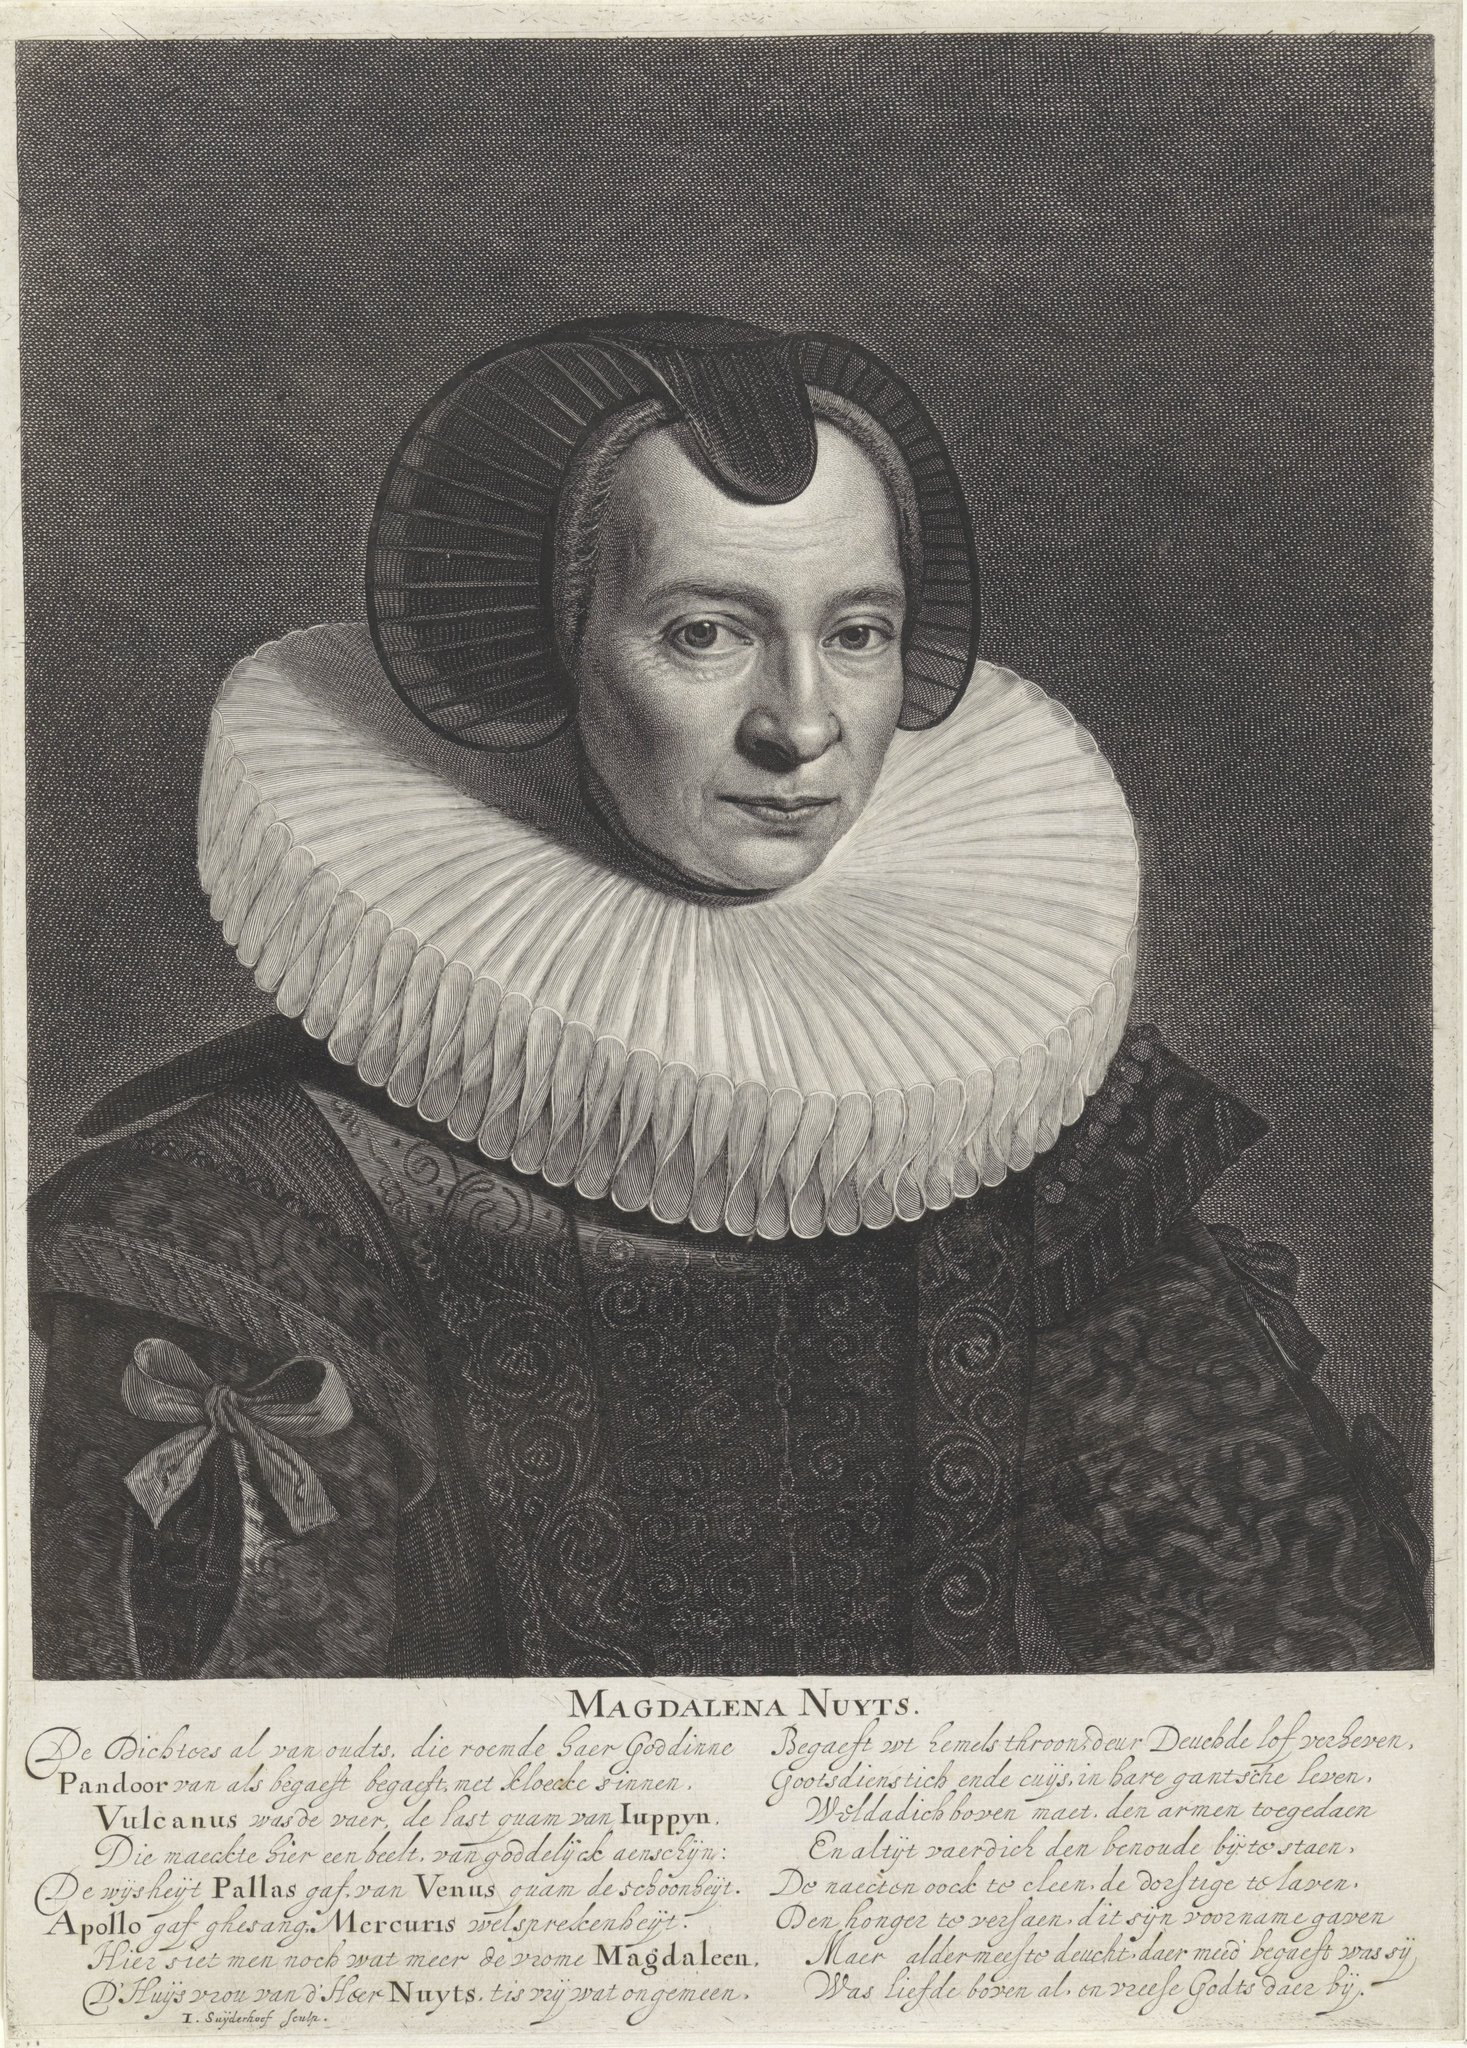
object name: print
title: Portret van Magdalena Nuyts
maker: jonas suyderhoef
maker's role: draughtsman, print maker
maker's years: 1613-1686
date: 1631-1686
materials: paper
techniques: engraving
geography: haarlem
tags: the hague, head-gear: cap (+ women's clothes), neck-gear ~ clothing (with name) (+ women's clothes)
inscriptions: title: ‘MAGDALENA NUYTS’, signature: ‘I. Suyderhoef sculp.’, poem: ‘De dichters al van ouds, die roemde haer Godinne...Hier siet men noch wat meer de vrome Magdaleen/ D Huysvrou van d'Heer Nuyts, tis vrij wat ongemeen....en vreese Godts daerbij.’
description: Portret van Magdalena Nuyts, de echtgenote van David Nuyts, met een brede plooikraag. Onderaan in de marge twee achtregelige verzen in het Nederlands.